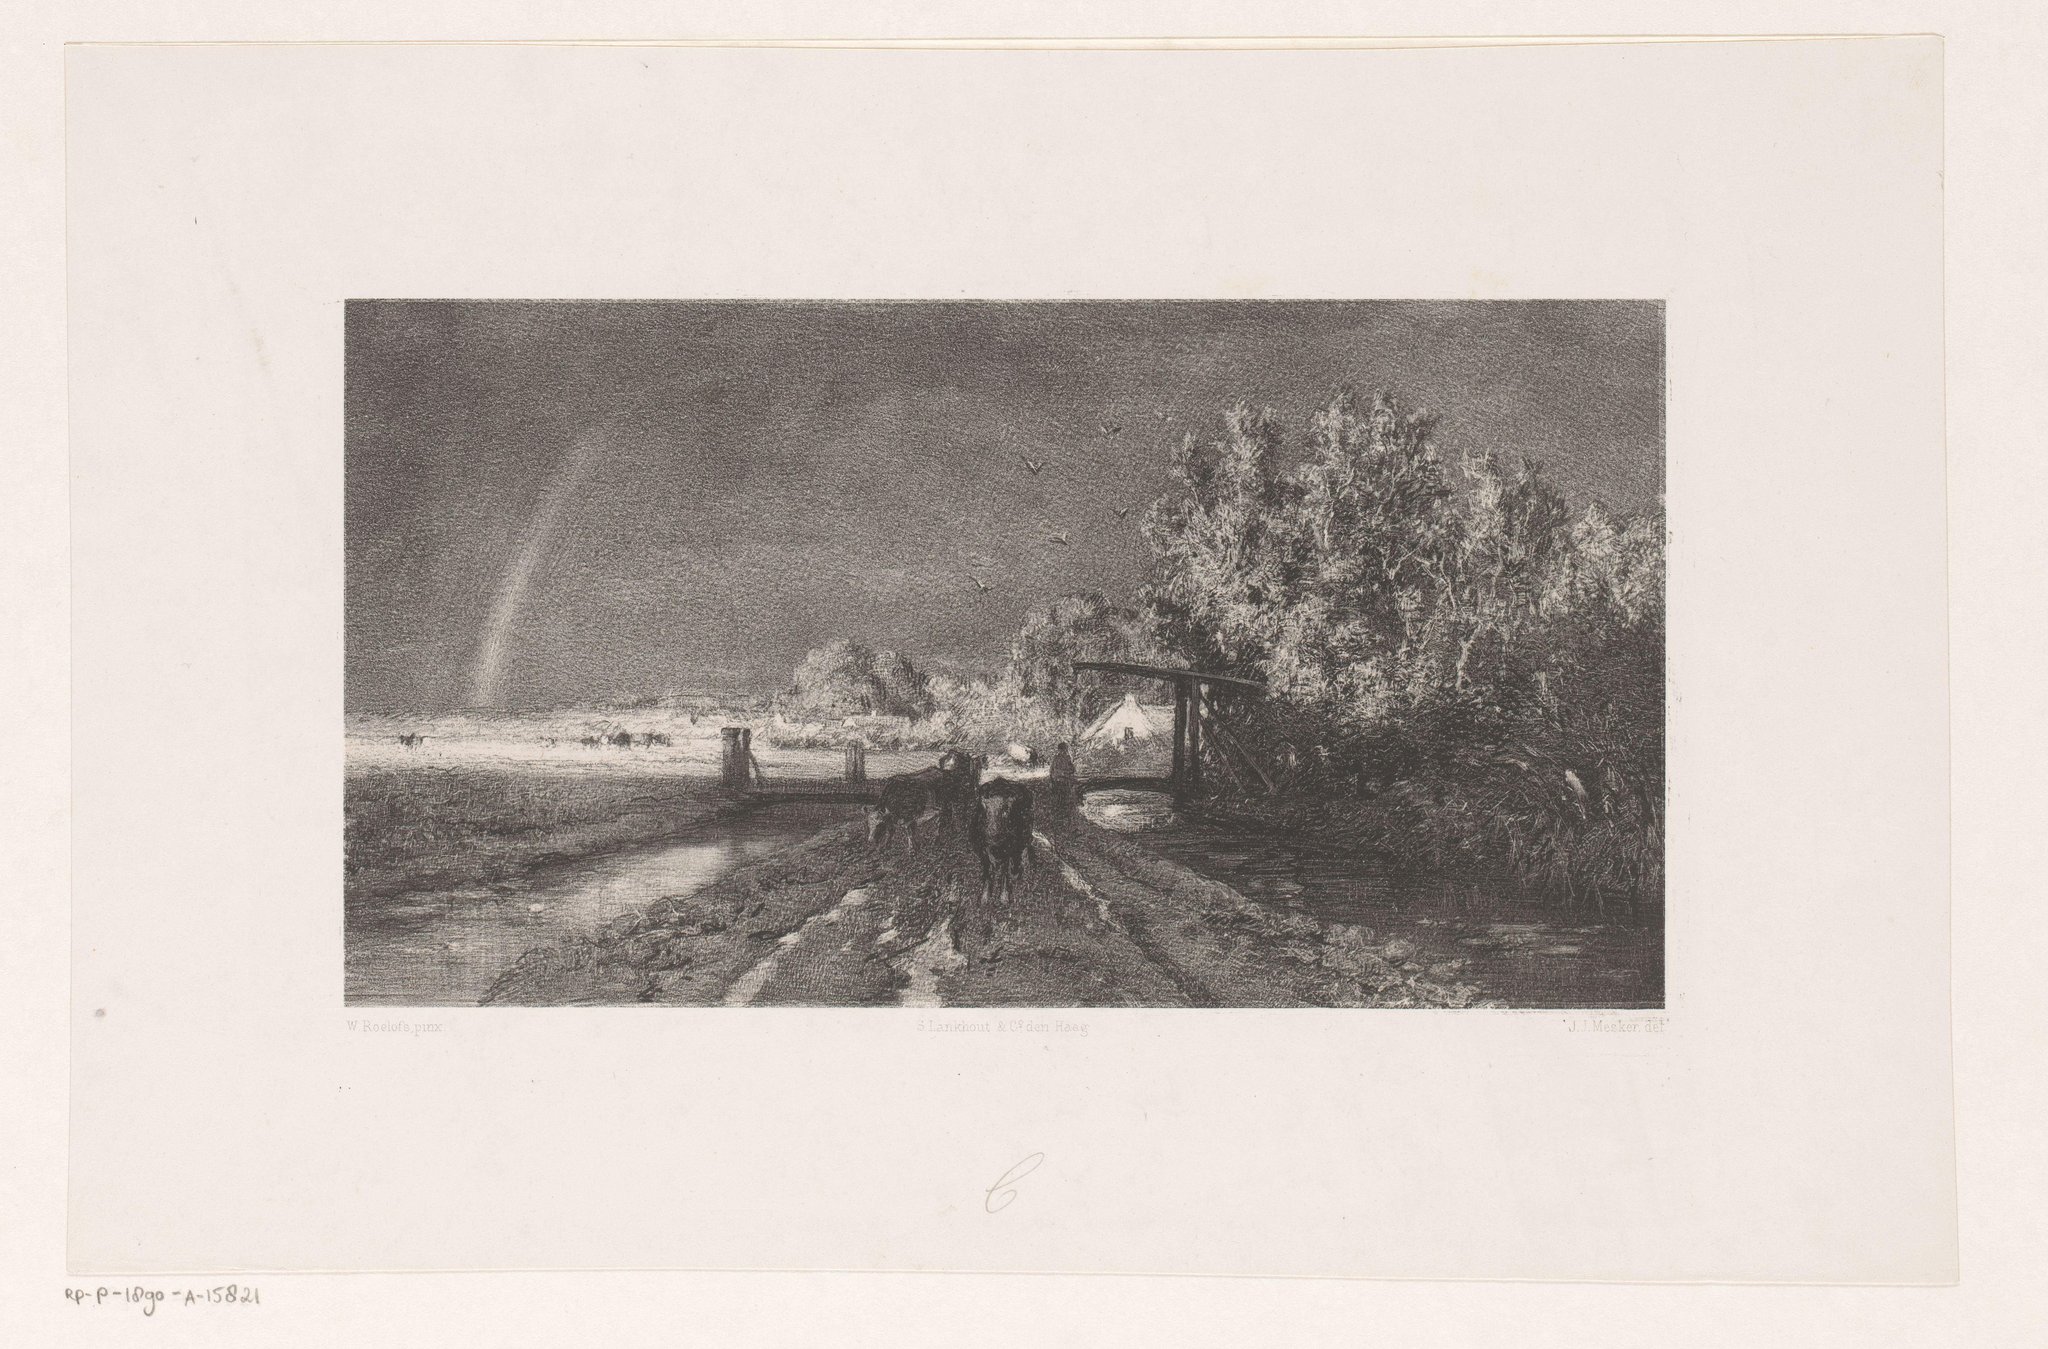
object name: print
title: Landschap met regenboog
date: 1877-1890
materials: paper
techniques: lithograph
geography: the hague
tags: cow, polder, reclaimed land, small canal, ditch, rainbow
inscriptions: collector's mark: Lugt 2228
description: In het midden, op een zandweg tussen twee sloten, lopen koeien en een man. Rechts een ophaalbrug en verderop een boerderij. Links een weiland met koeien en een regenboog.